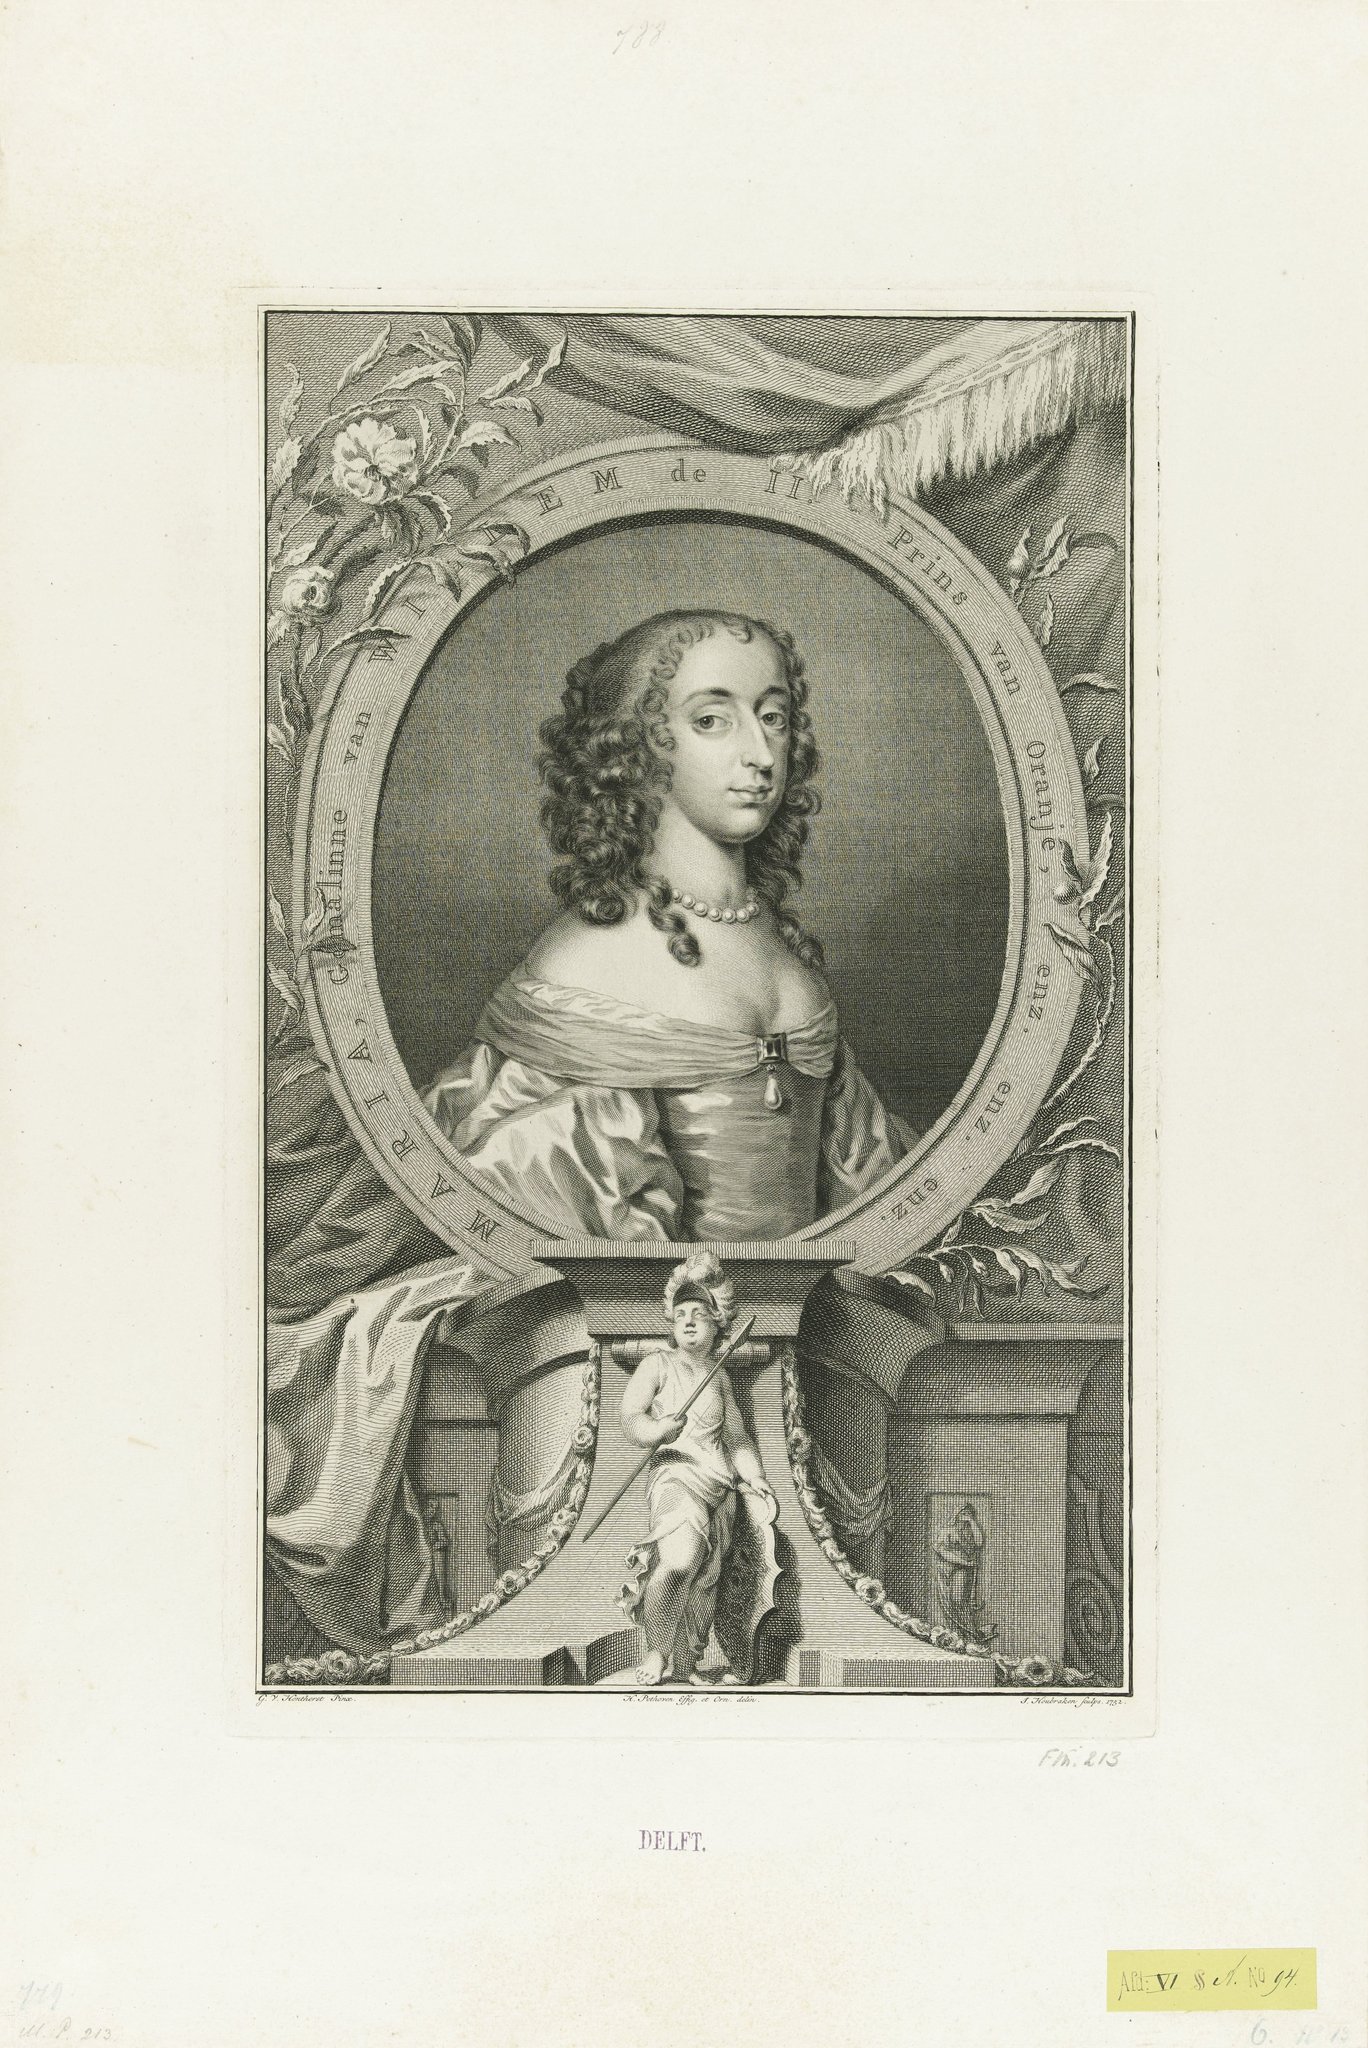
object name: print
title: Portret van Maria Henrietta Stuart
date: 1752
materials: paper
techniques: engraving, etching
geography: amsterdam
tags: london, mary henrietta stuart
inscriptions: collector's mark: ‘JNV’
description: Portret van Maria Henrietta in een ovaal met randschrift. Rondom ligt een aantal allegorische objecten.